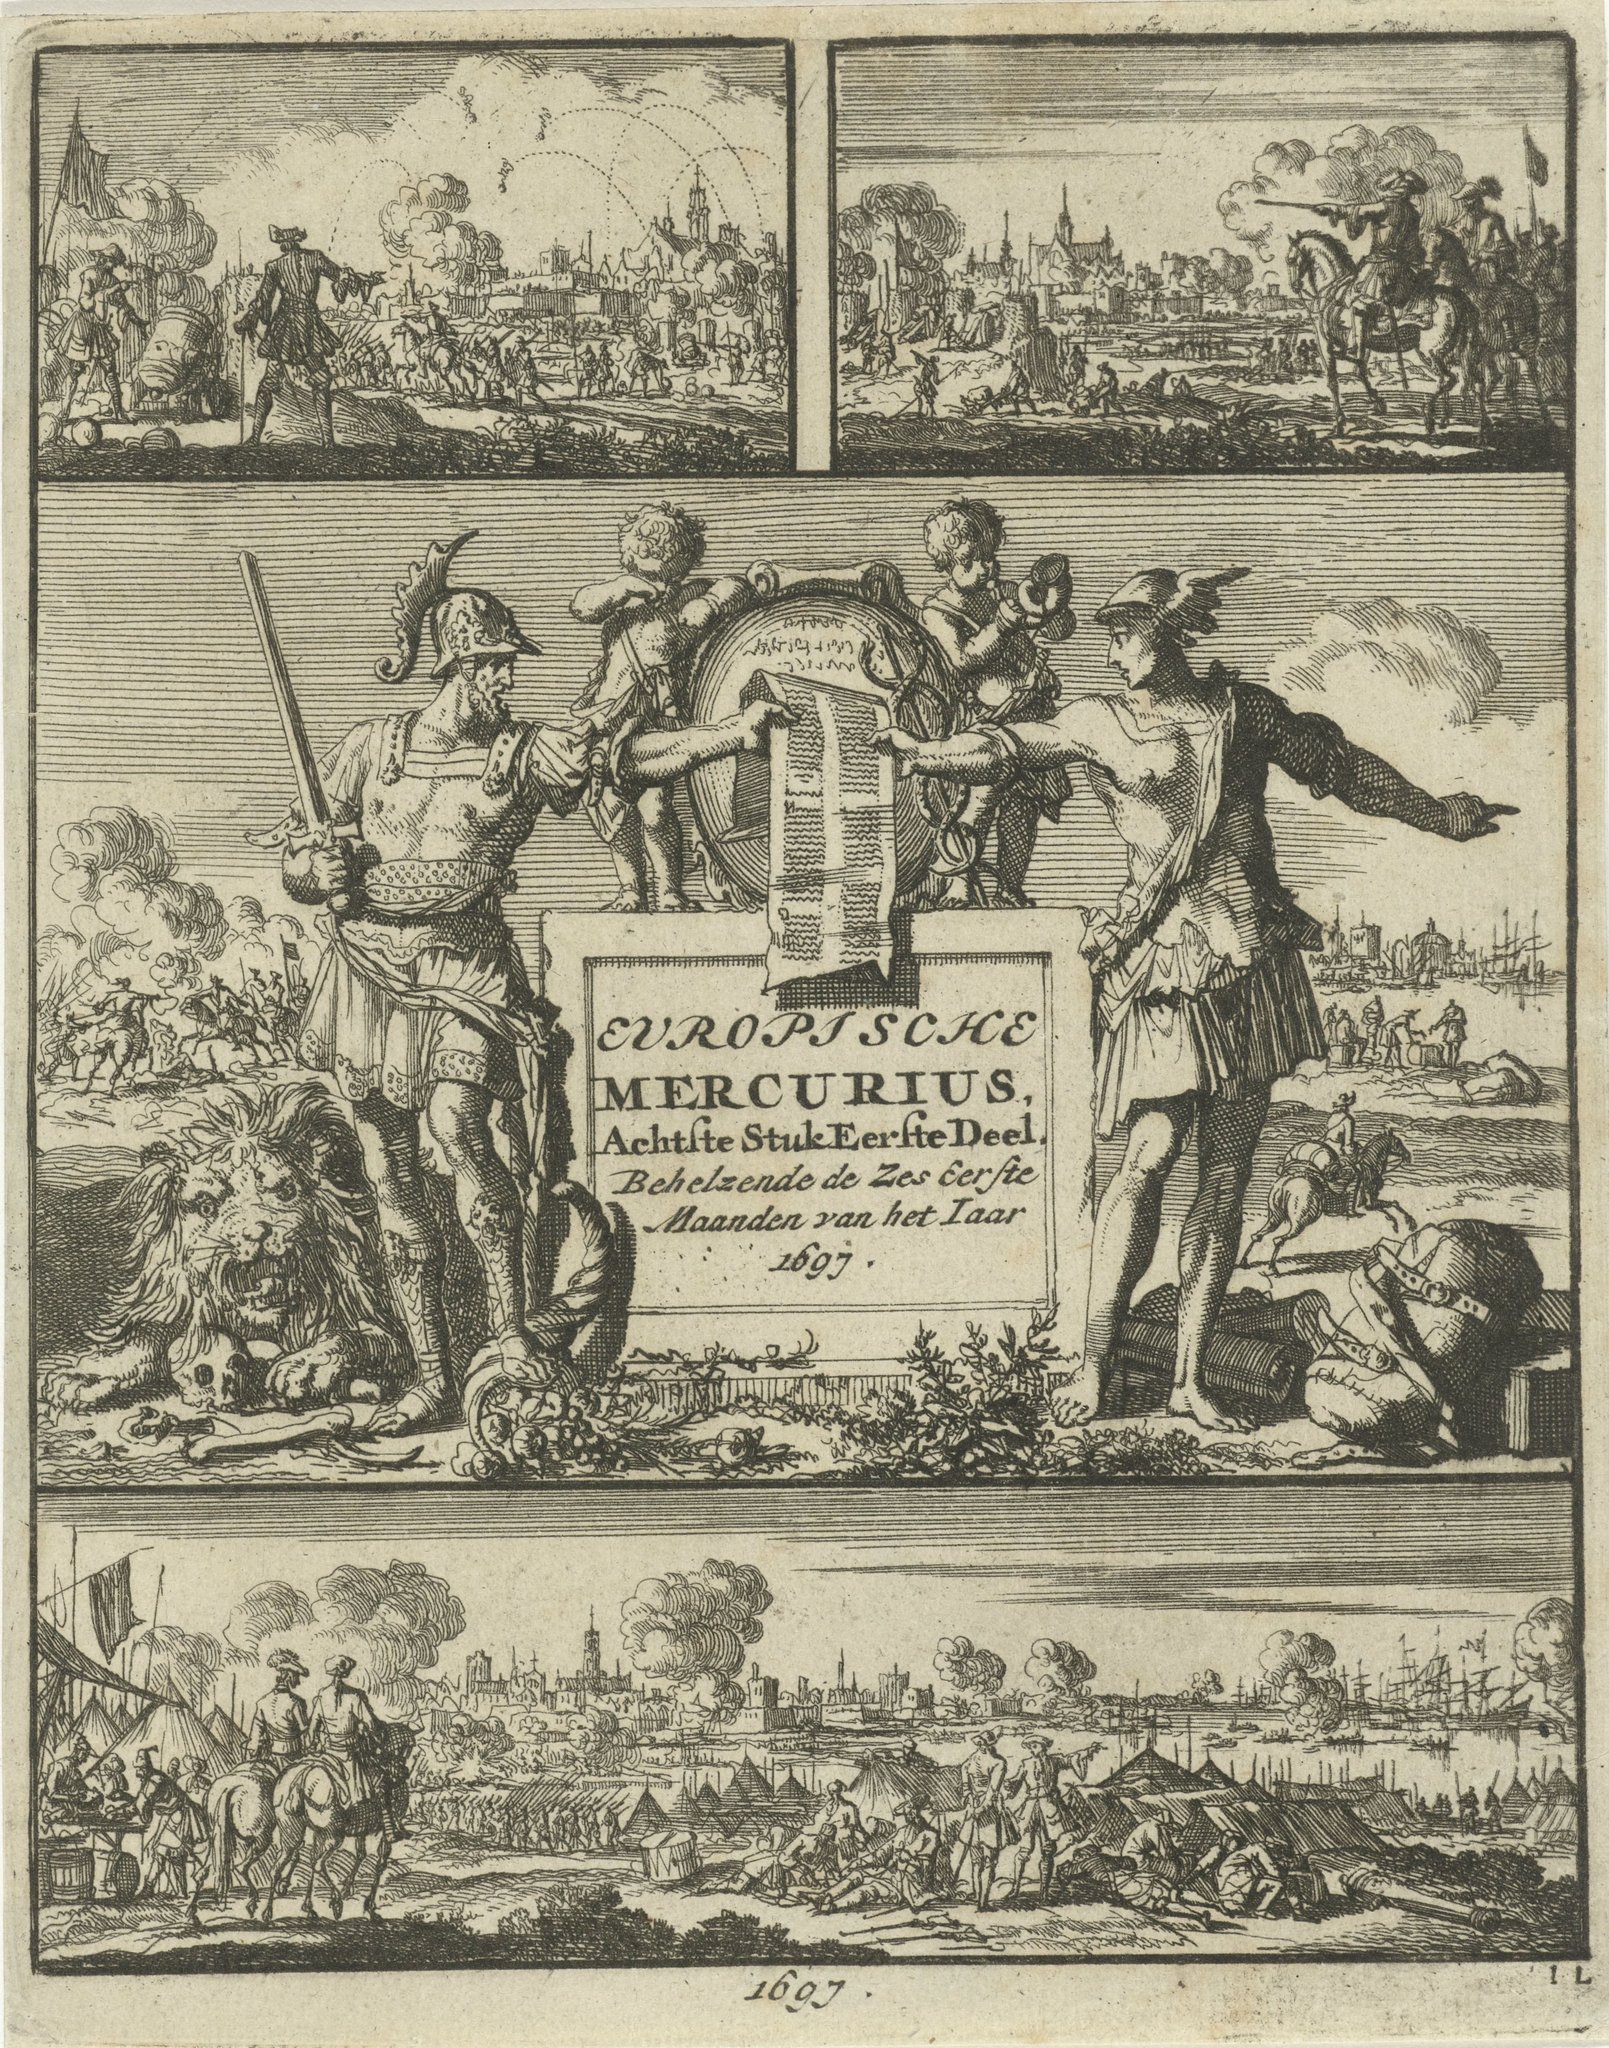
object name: print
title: Mars en Mercurius houden samen een beschreven papier vast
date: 1697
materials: paper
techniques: etching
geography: amsterdam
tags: (military) camp with tents, (story of) mars (ares), (story of) mercury (hermes), bag, attack ~ siege, battle (+ cavalry, horsemen), merchant shipping, shipping trade, beasts of prey, predatory animals: lion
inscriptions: collector's mark: Lugt 2228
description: Mars en Mercurius houden samen een beschreven papier vast. Naast Mars ligt een leeuw met een doodshoofd, hierachter vindt een ruitergevecht plaats. Naast Mercurius ligt een reiszak, op de achtergrond worden goederen in een haven verhandeld. Boven deze voorstelling twee verbeeldingen van een belegering. Onderaan een voorstelling van een legerkamp, opgezet nabij een stad.